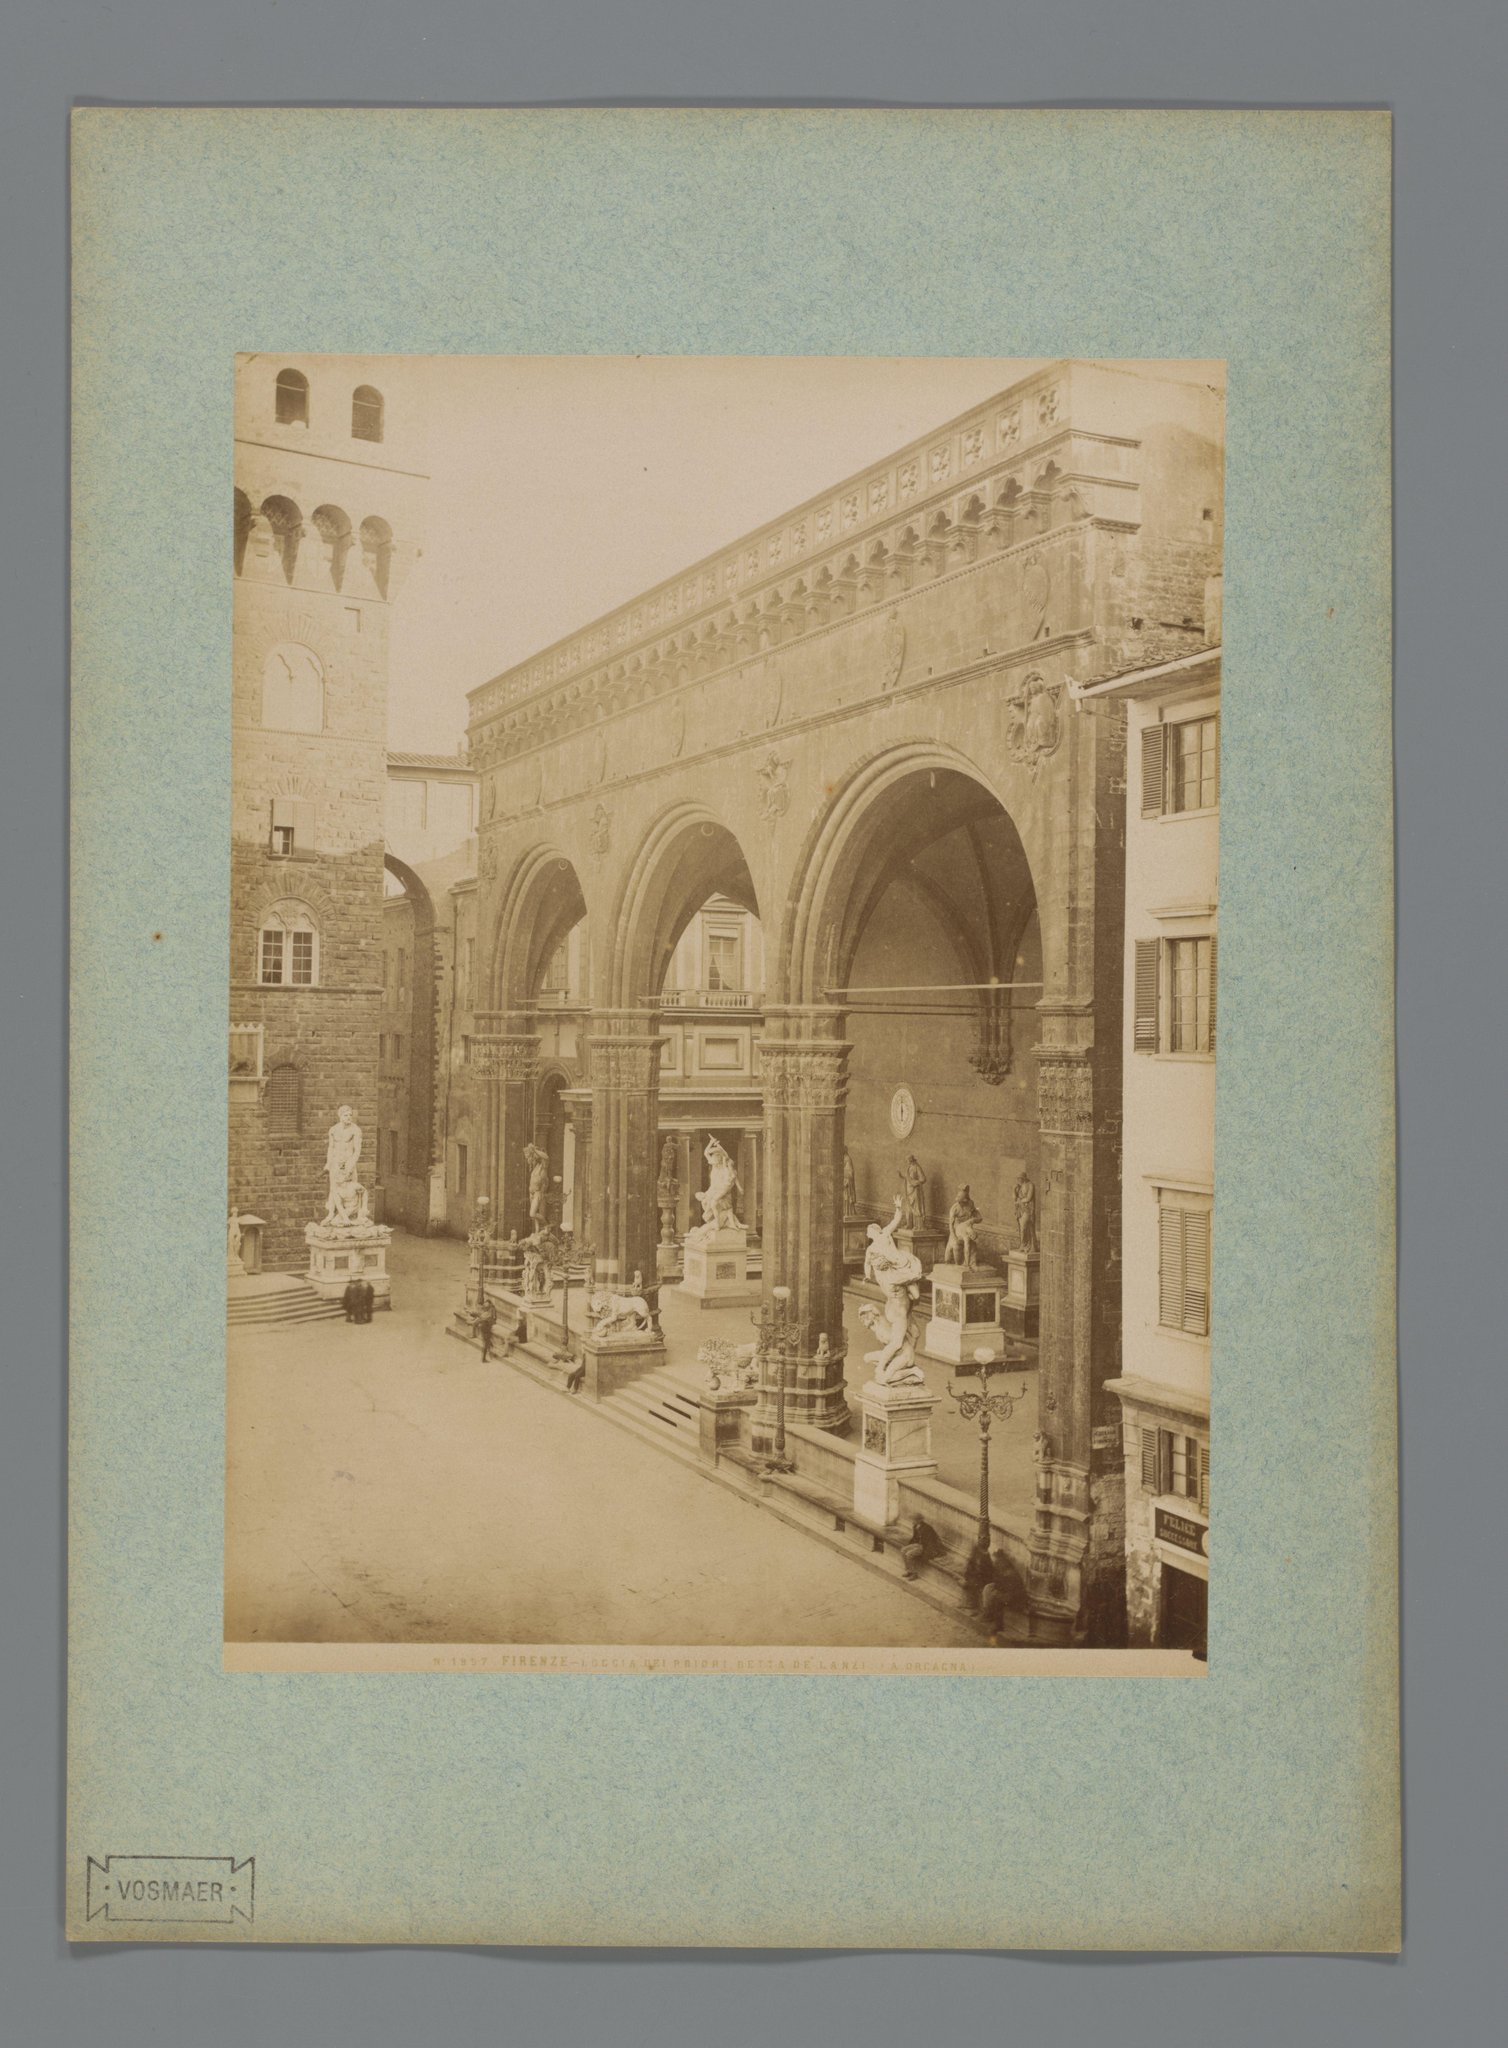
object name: photograph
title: Firenze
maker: andrea di cione named orcagna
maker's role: painter, sculptor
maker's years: 1320-1368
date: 1851-1890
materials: cardboard, paper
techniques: albumen print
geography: florence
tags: gallery of sculptures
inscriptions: collector's mark: ‘VOSMAER’, number: ‘No. 1957’